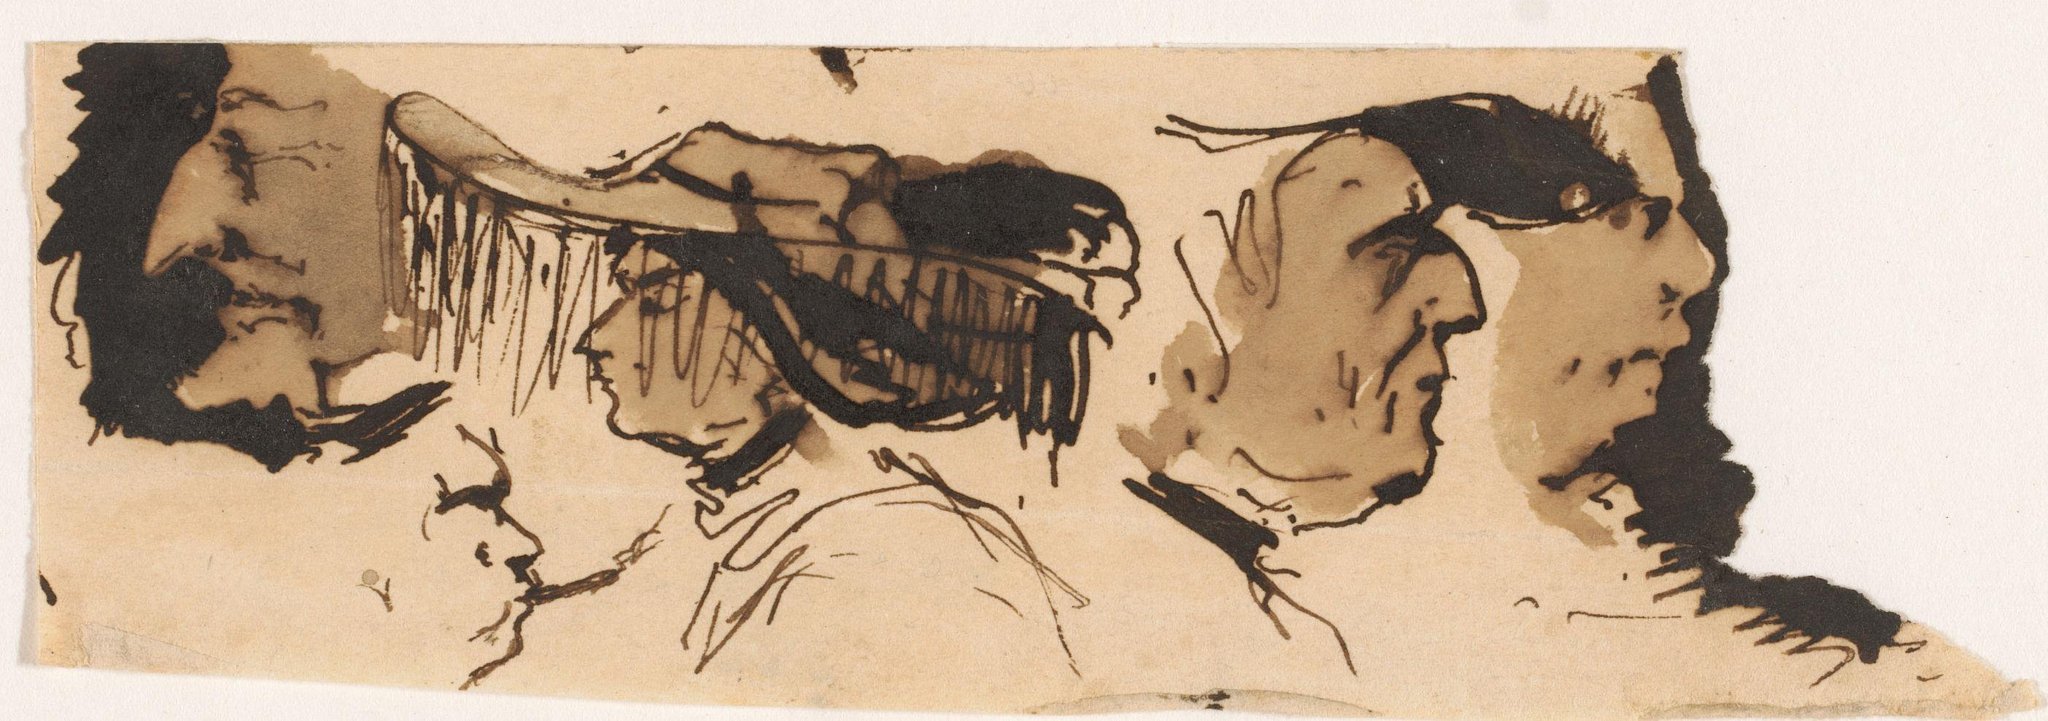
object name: drawing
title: Vijf koppen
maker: johannes tavenraat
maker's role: draughtsman, painter, print maker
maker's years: 1809-1881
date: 1840-1880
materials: ink, paper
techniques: brush, pen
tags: caricatures (human types)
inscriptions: collector's mark: Lugt 2228